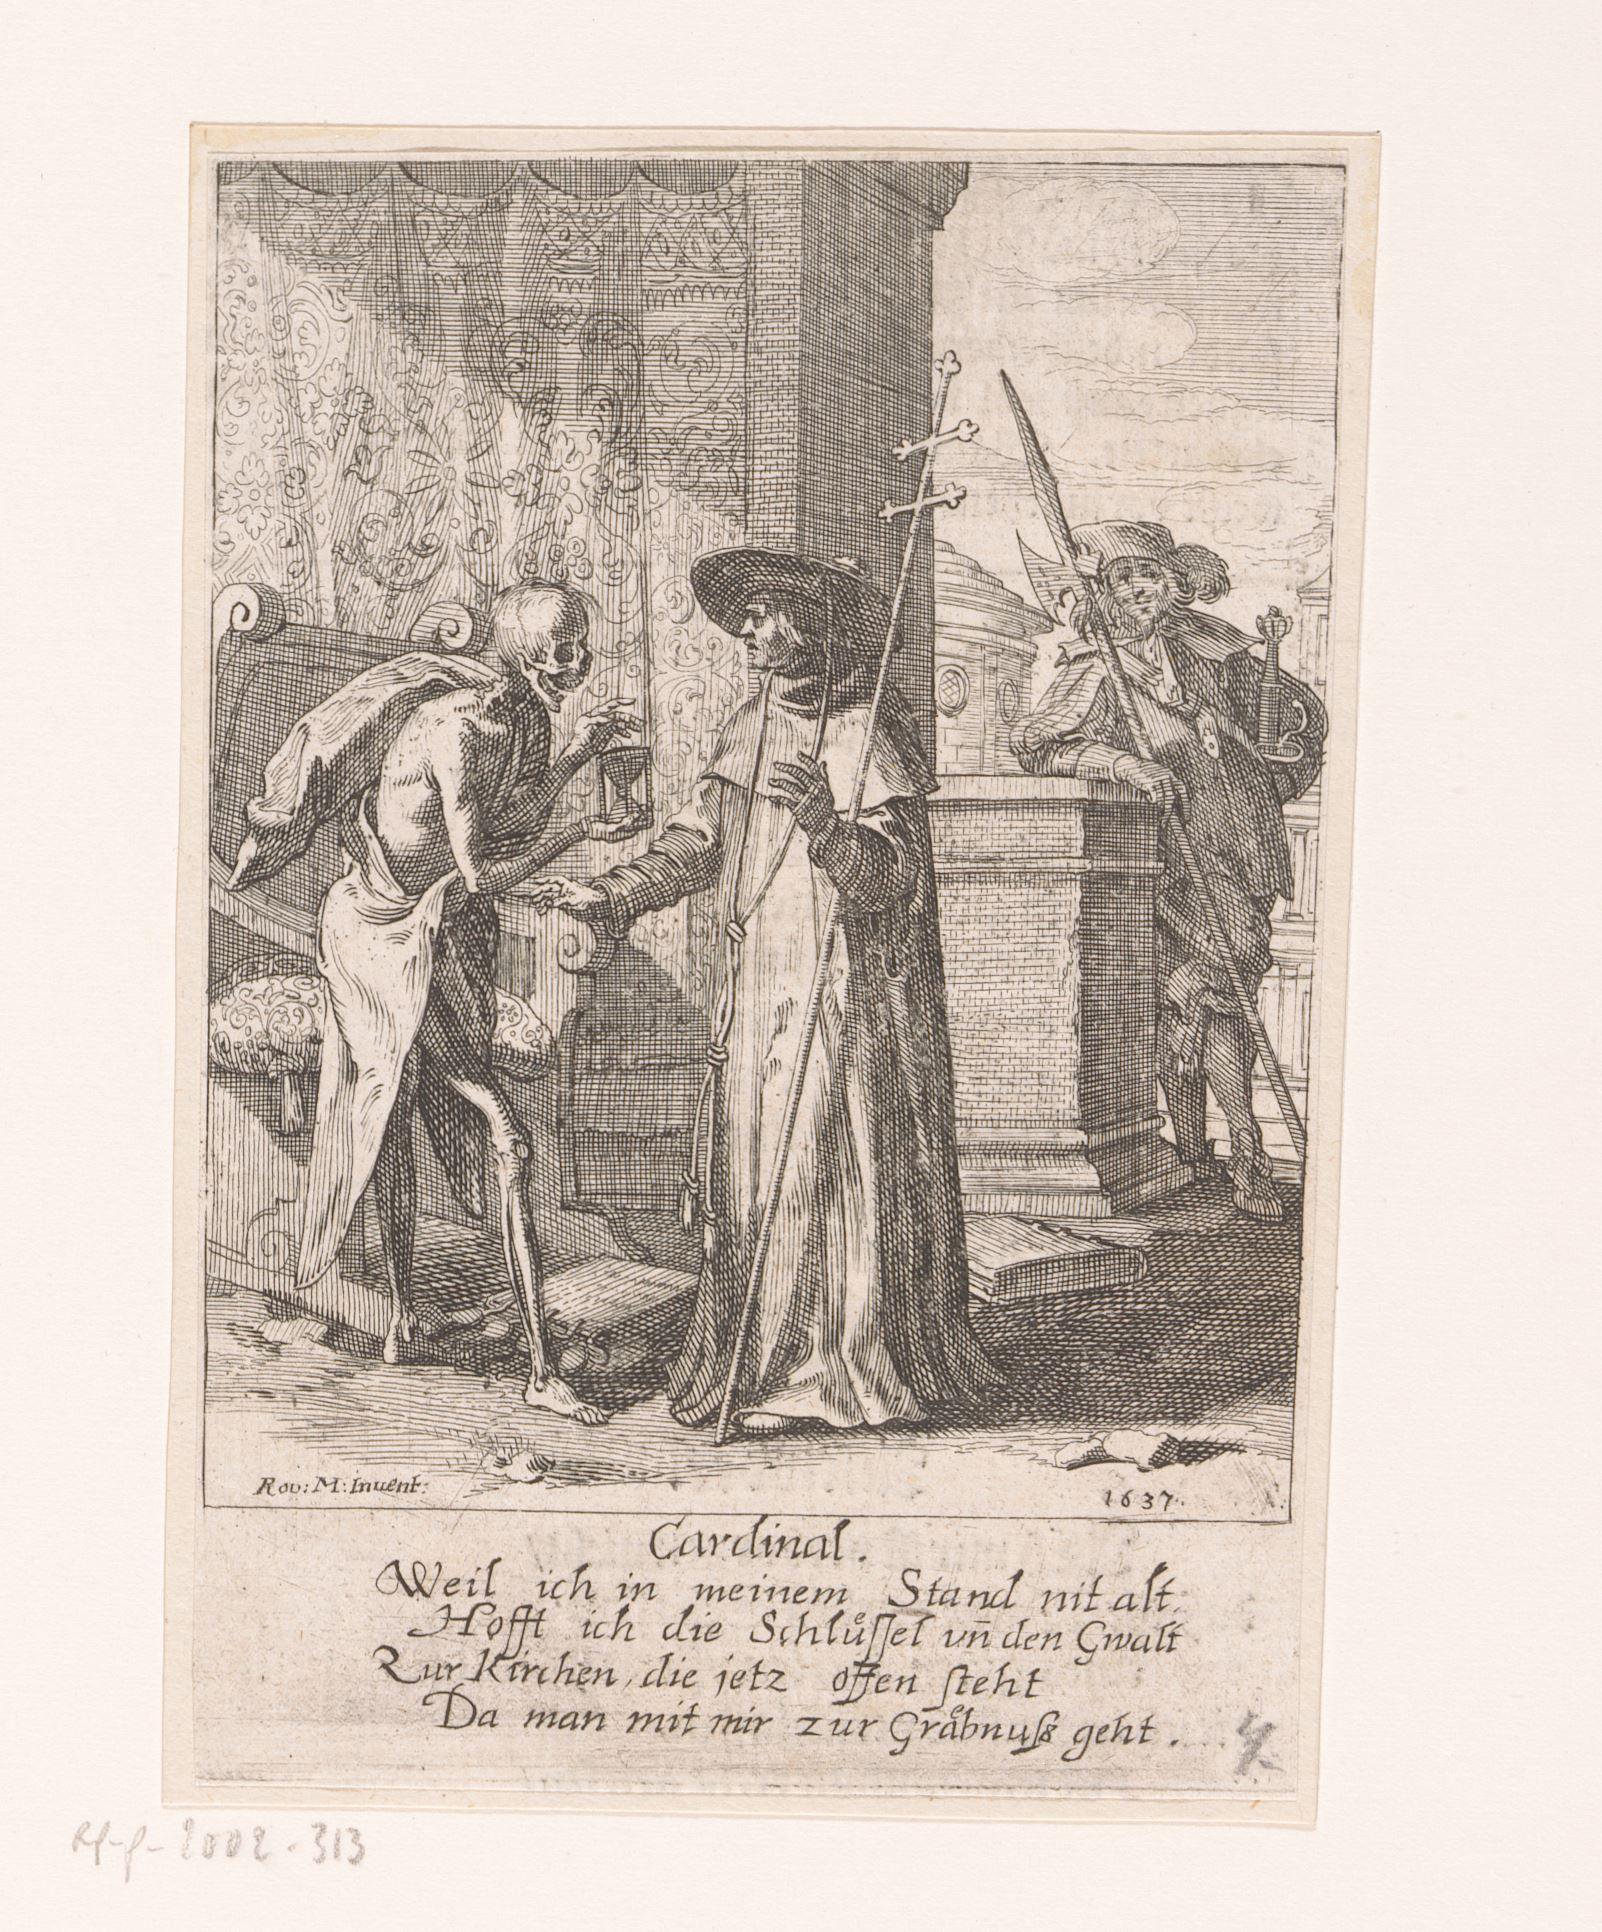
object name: print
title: Kardinaal en de dood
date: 1637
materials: paper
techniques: etching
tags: cardinal, personifications of death; 'morte' (ripa), dance of death; death together with one or more human beings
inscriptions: collector's mark: Lugt 2233, collector's mark: Lugt 2228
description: Prent uit: Meyer, Rudolph. Sterbenspiegel, das ist sonnenklare Vorstellung menschlicher Nichtigkeit durch alle Ständ und Geschlechter (...). Zürich: J.J. Bodmer, 1650.